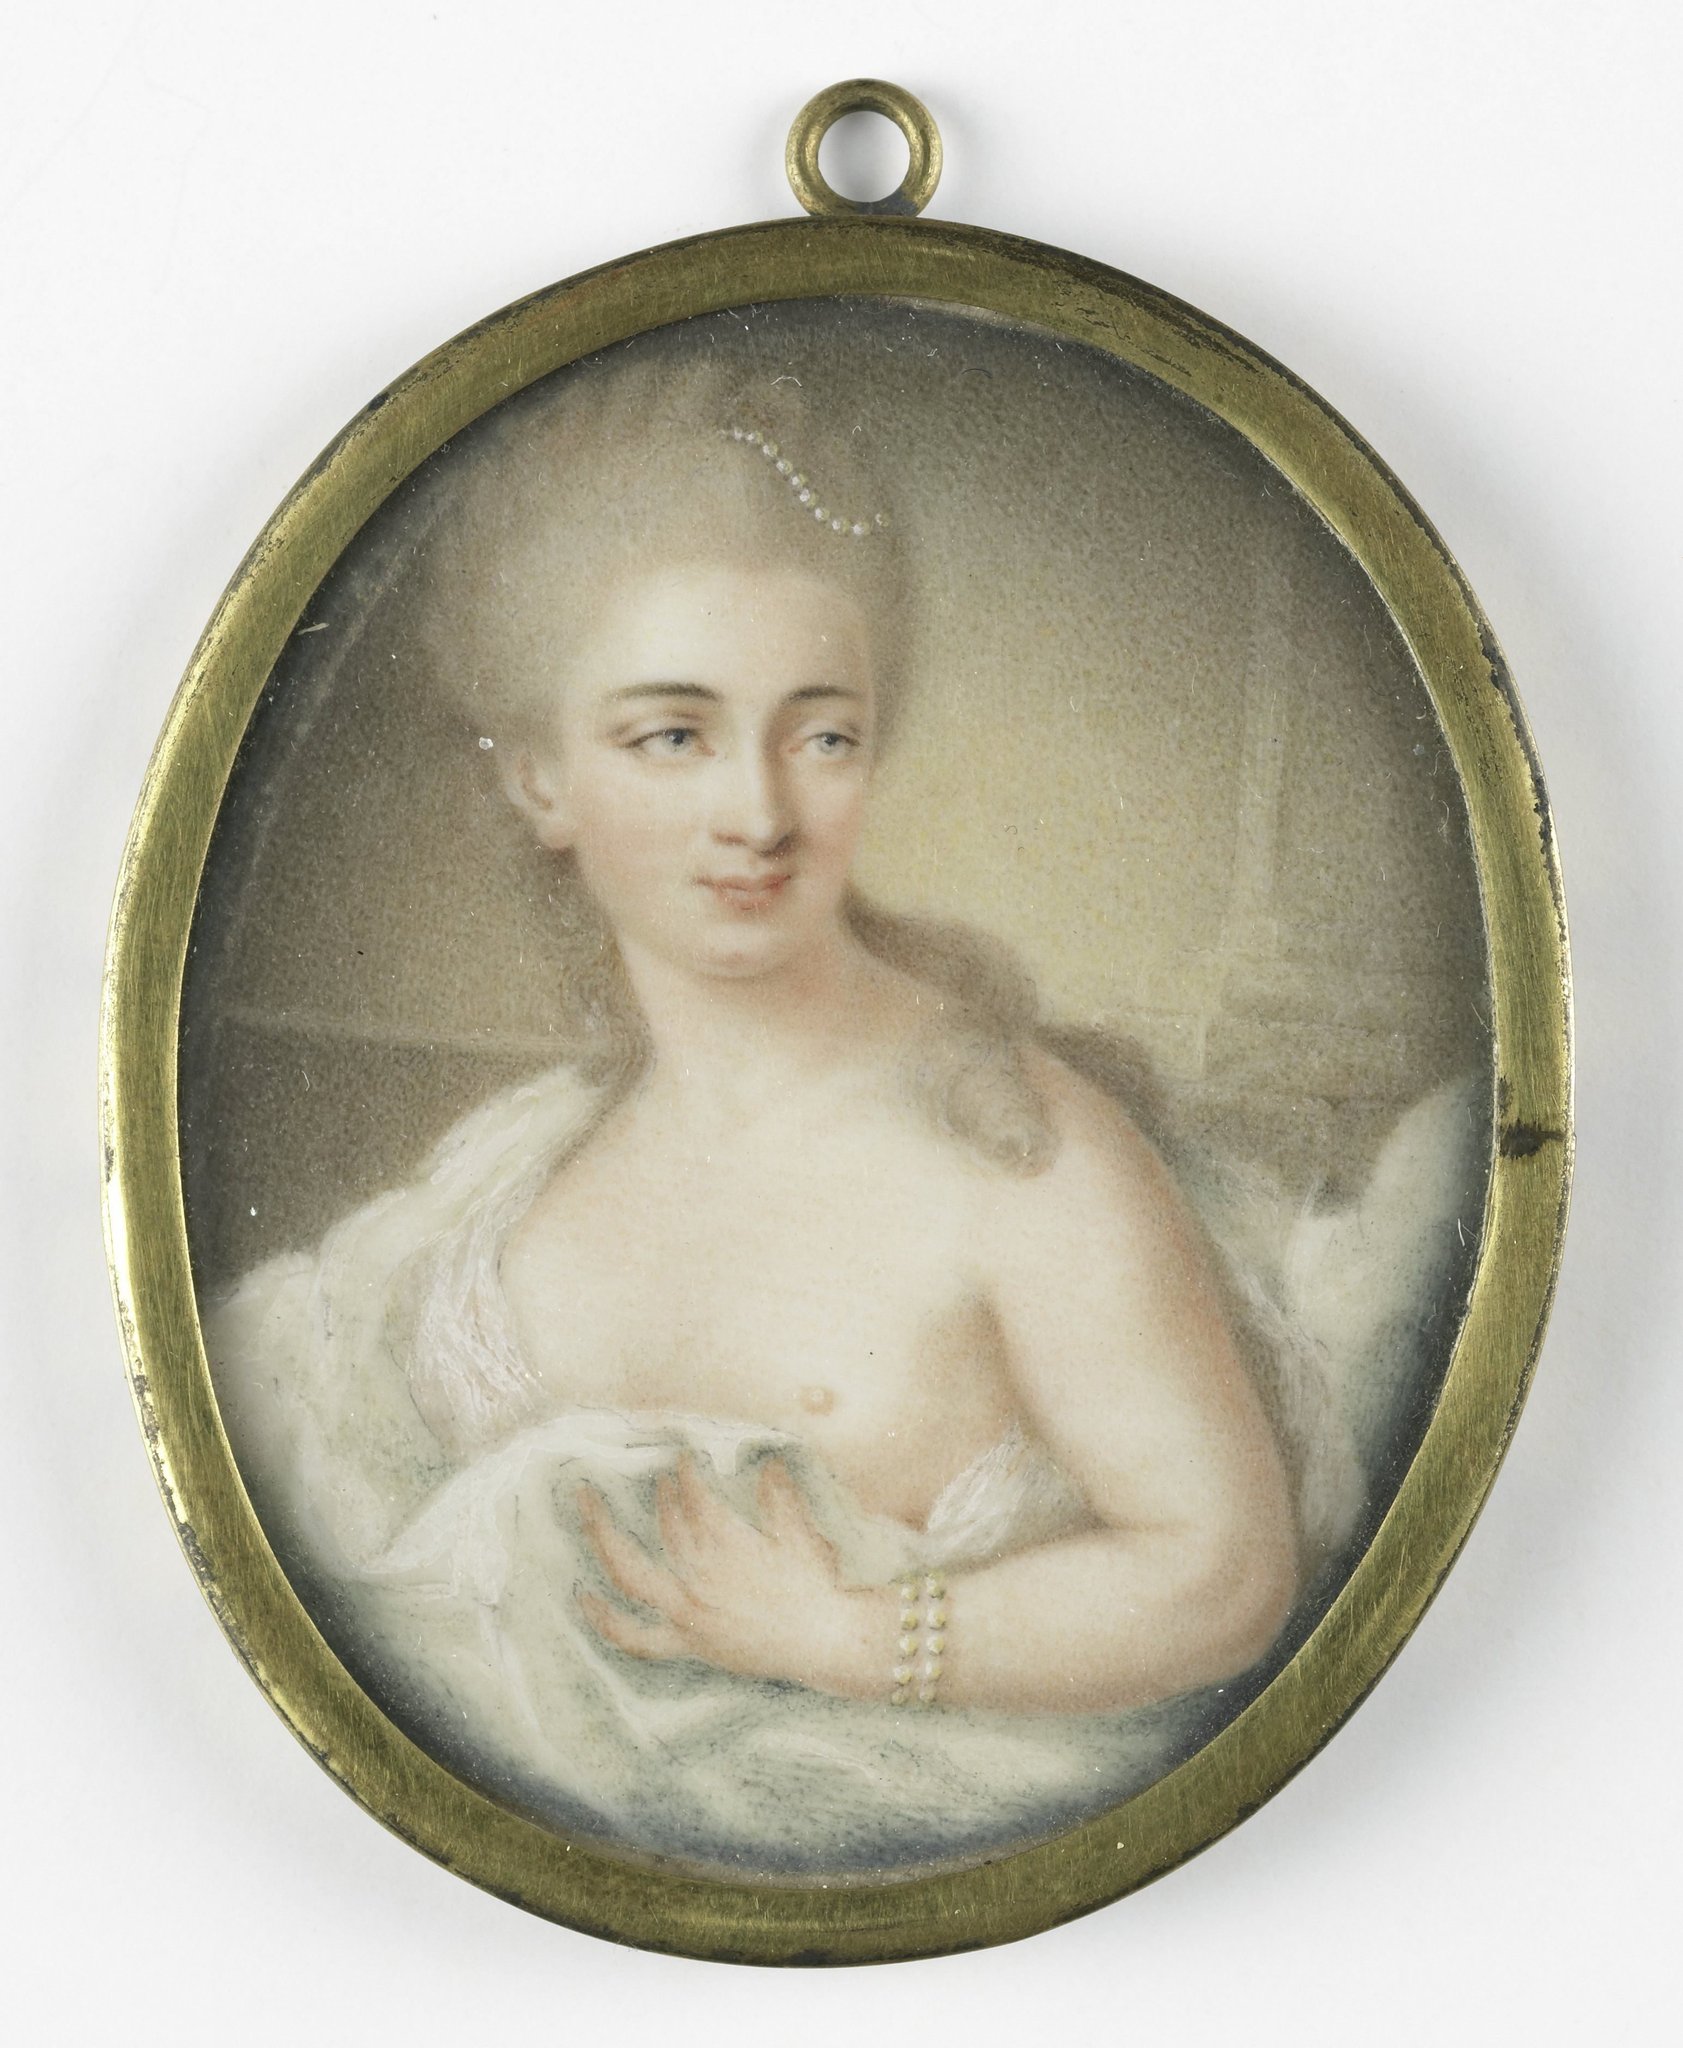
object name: painting, miniature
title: Portret van een jonge vrouw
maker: Anonymous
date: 1775-1795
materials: ivory, metal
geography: france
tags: historical persons not known by name - bb - woman, the (nude) human figure; 'corpo humano' (ripa) - aa - female human figure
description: Portret van een jonge vrouw met een parelsnoer in het haar. Ten halven lijve, het hoofd naar rechts gekeerd. Met halfontbloot boezem. Onderdeel van de collectie portretminiaturen.